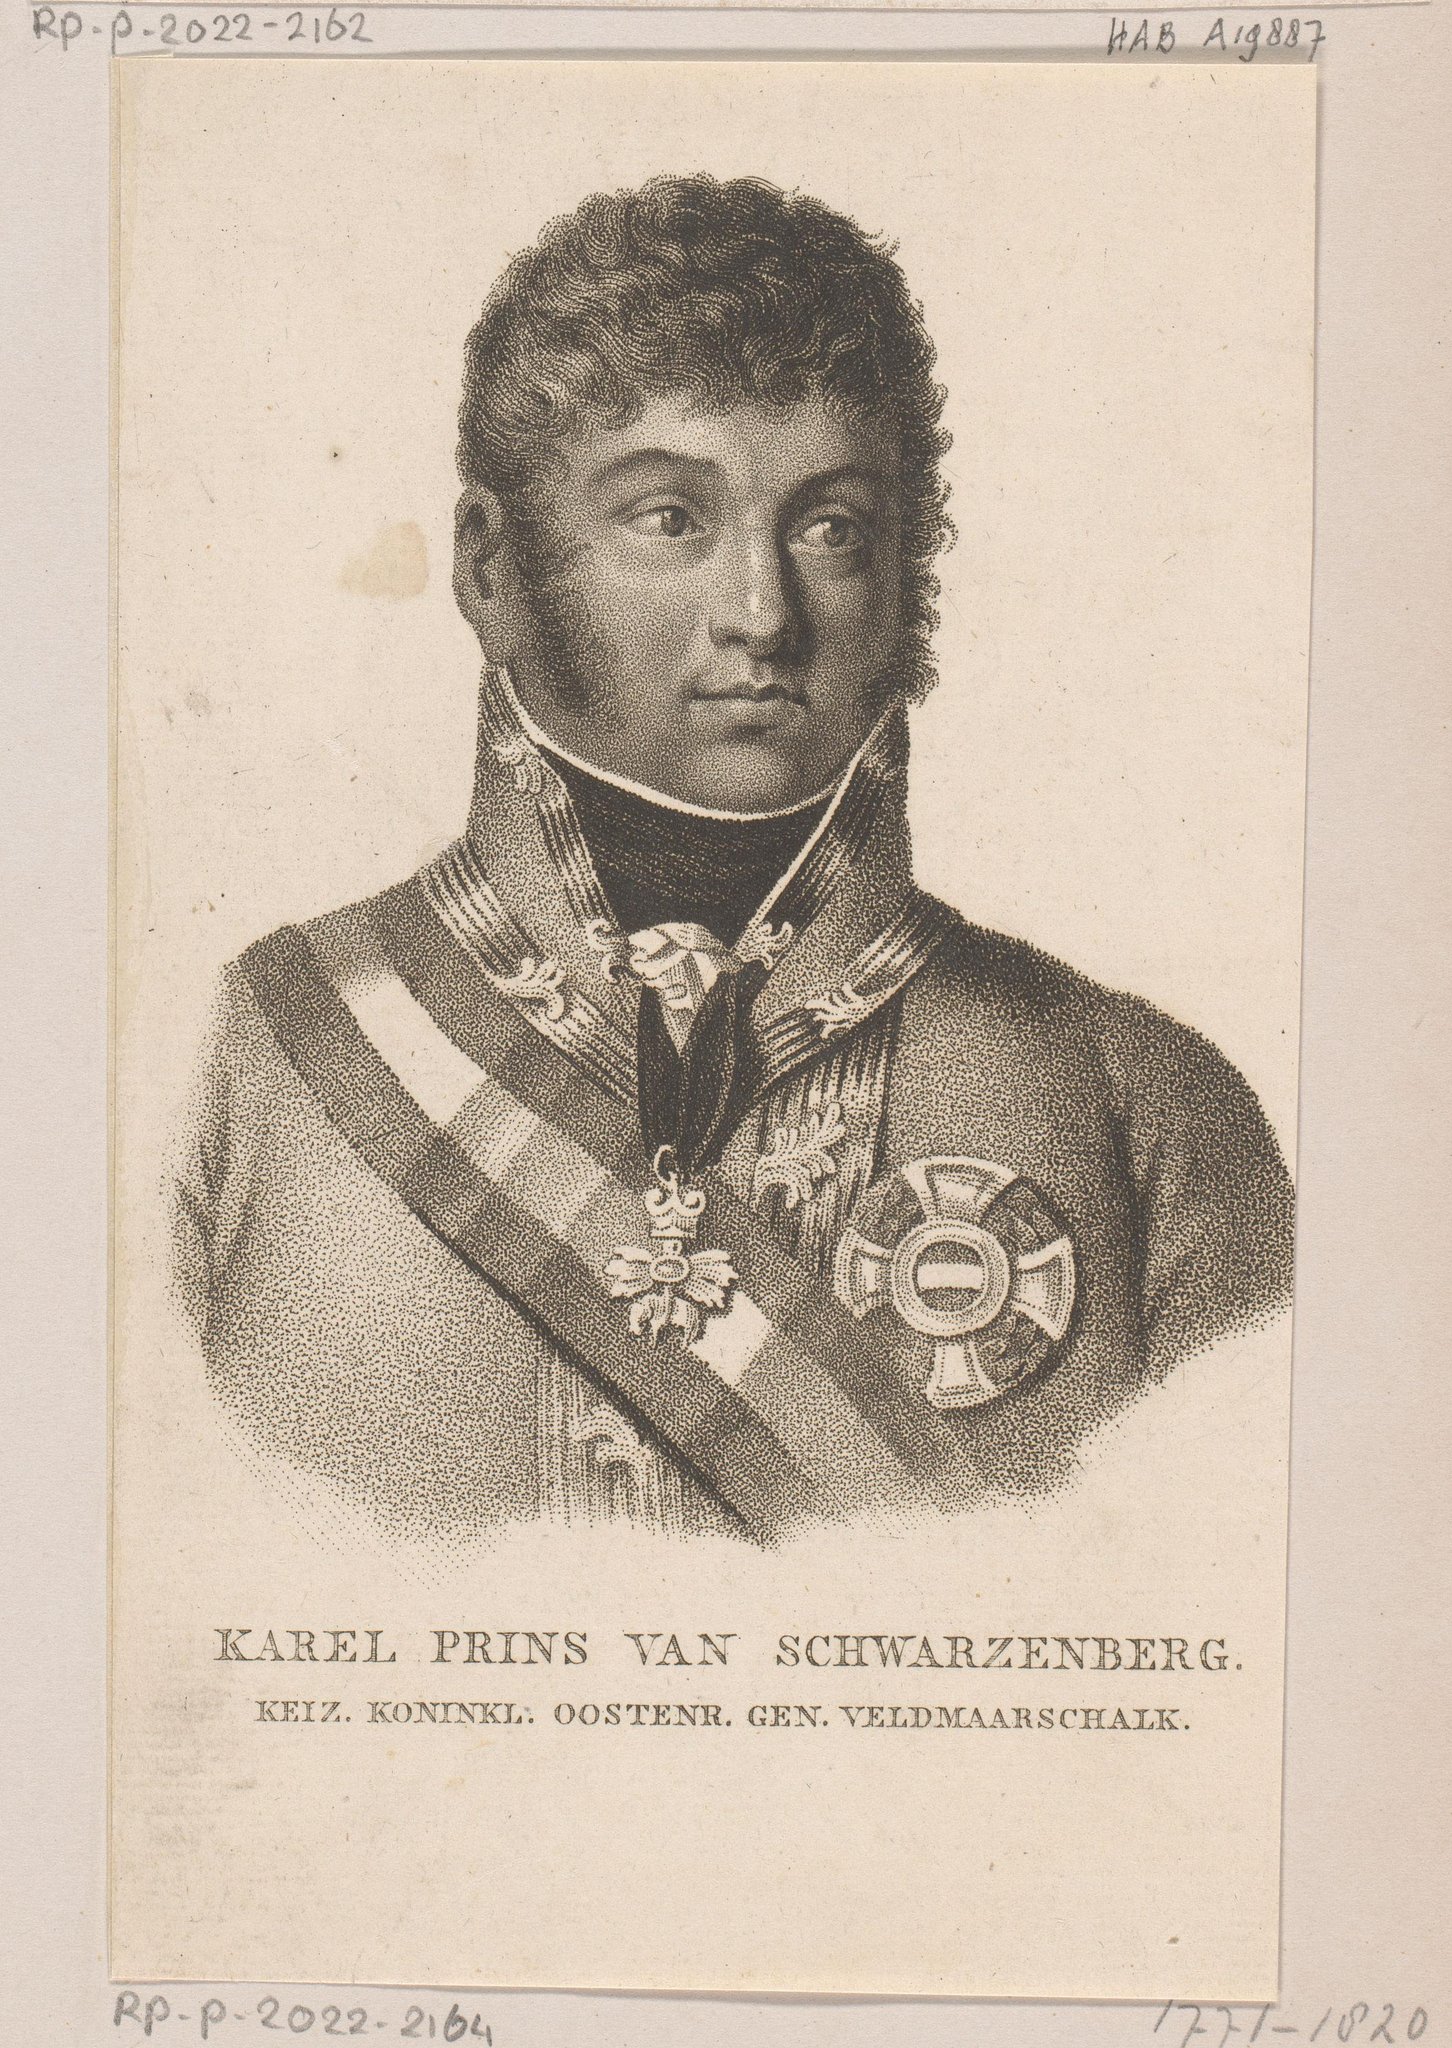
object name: print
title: Portret van Carl Philipp von Schwarzenberg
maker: Anonymous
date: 1812-1899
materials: paper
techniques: etching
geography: netherlands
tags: vienna, commander-in-chief, general, marshal, historical persons, knighthood order of the golden fleece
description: Met tweeregelig onderschrift in het Nederlands.